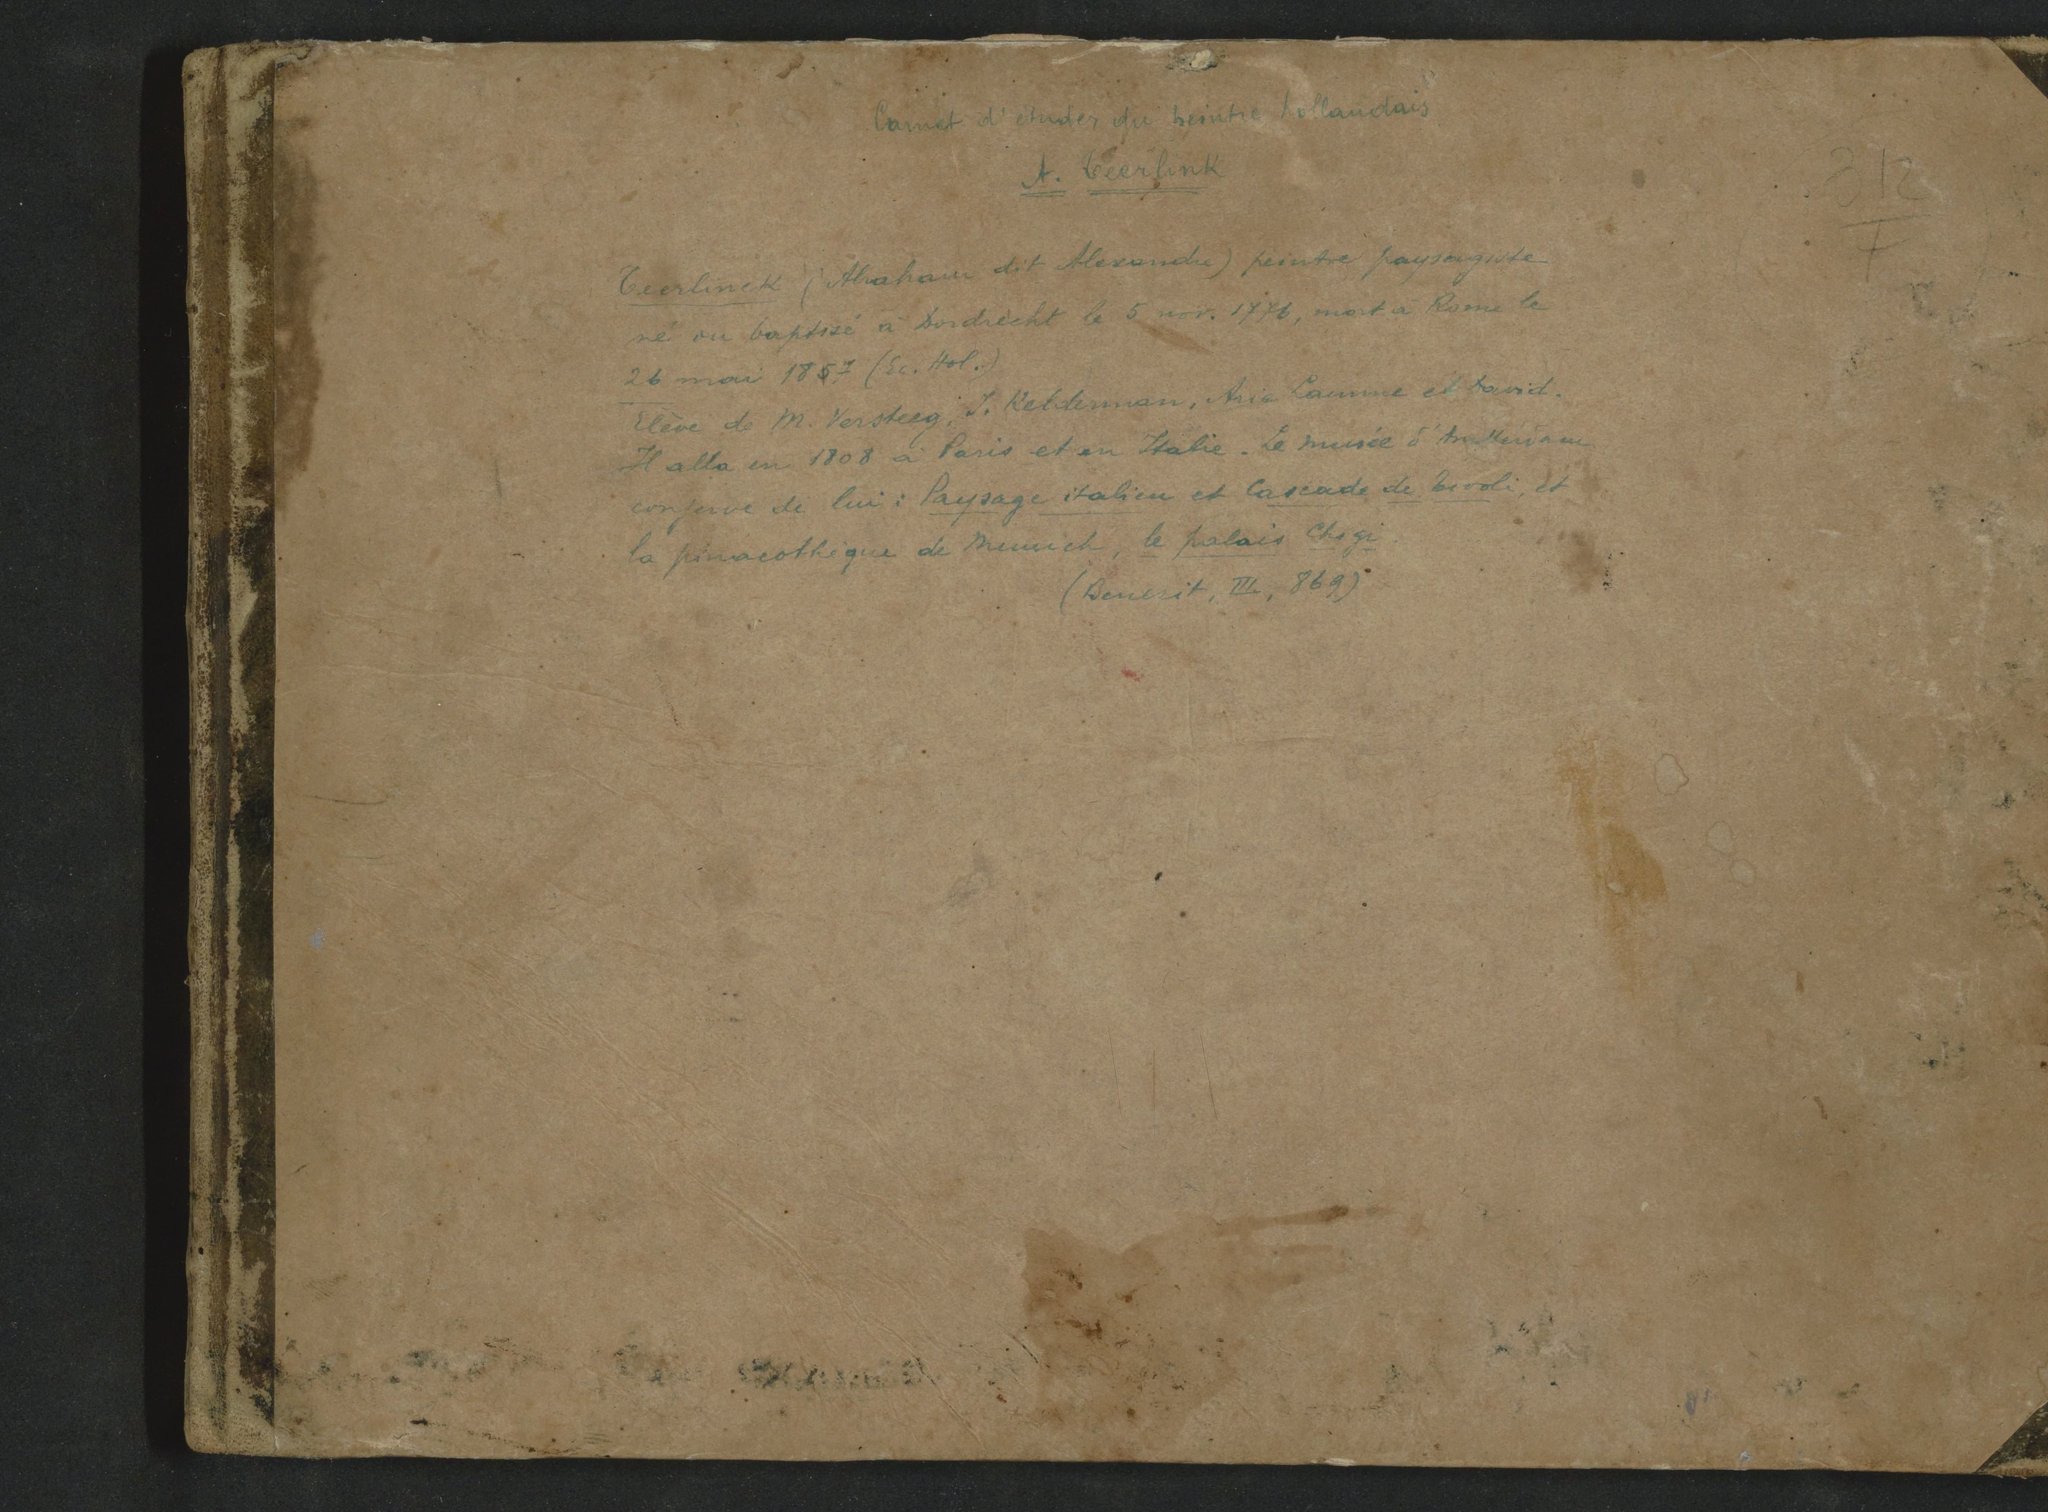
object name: sketchbook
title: Schetsboek met 28 bladen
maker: abraham teerlink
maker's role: draughtsman, painter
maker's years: 1776-1857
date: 1808-1857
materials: cardboard, chalk, ink, leather, paper, pencil, watercolor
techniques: brush, pen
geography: umbria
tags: animals, lake, mountains (+ landscape with figures, staffage), rome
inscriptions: annotation: ‘Carnet d'etudes du peintre hollandais/ A. Teerlink/ Teerlinck (Abraham dit Alexandre) peintre paysagiste ... (Benezit, III, 869)’, annotation: ‘Teerlink’, collector's mark: Lugt 2228a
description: De volgende bladen uit het schetsboek zijn blanco: 1(V), 2(R), 9(R), 10(V), 11(V), 13(V), 17(V), 18(R), 20(V) 22(V), 23(R) en 27(V).